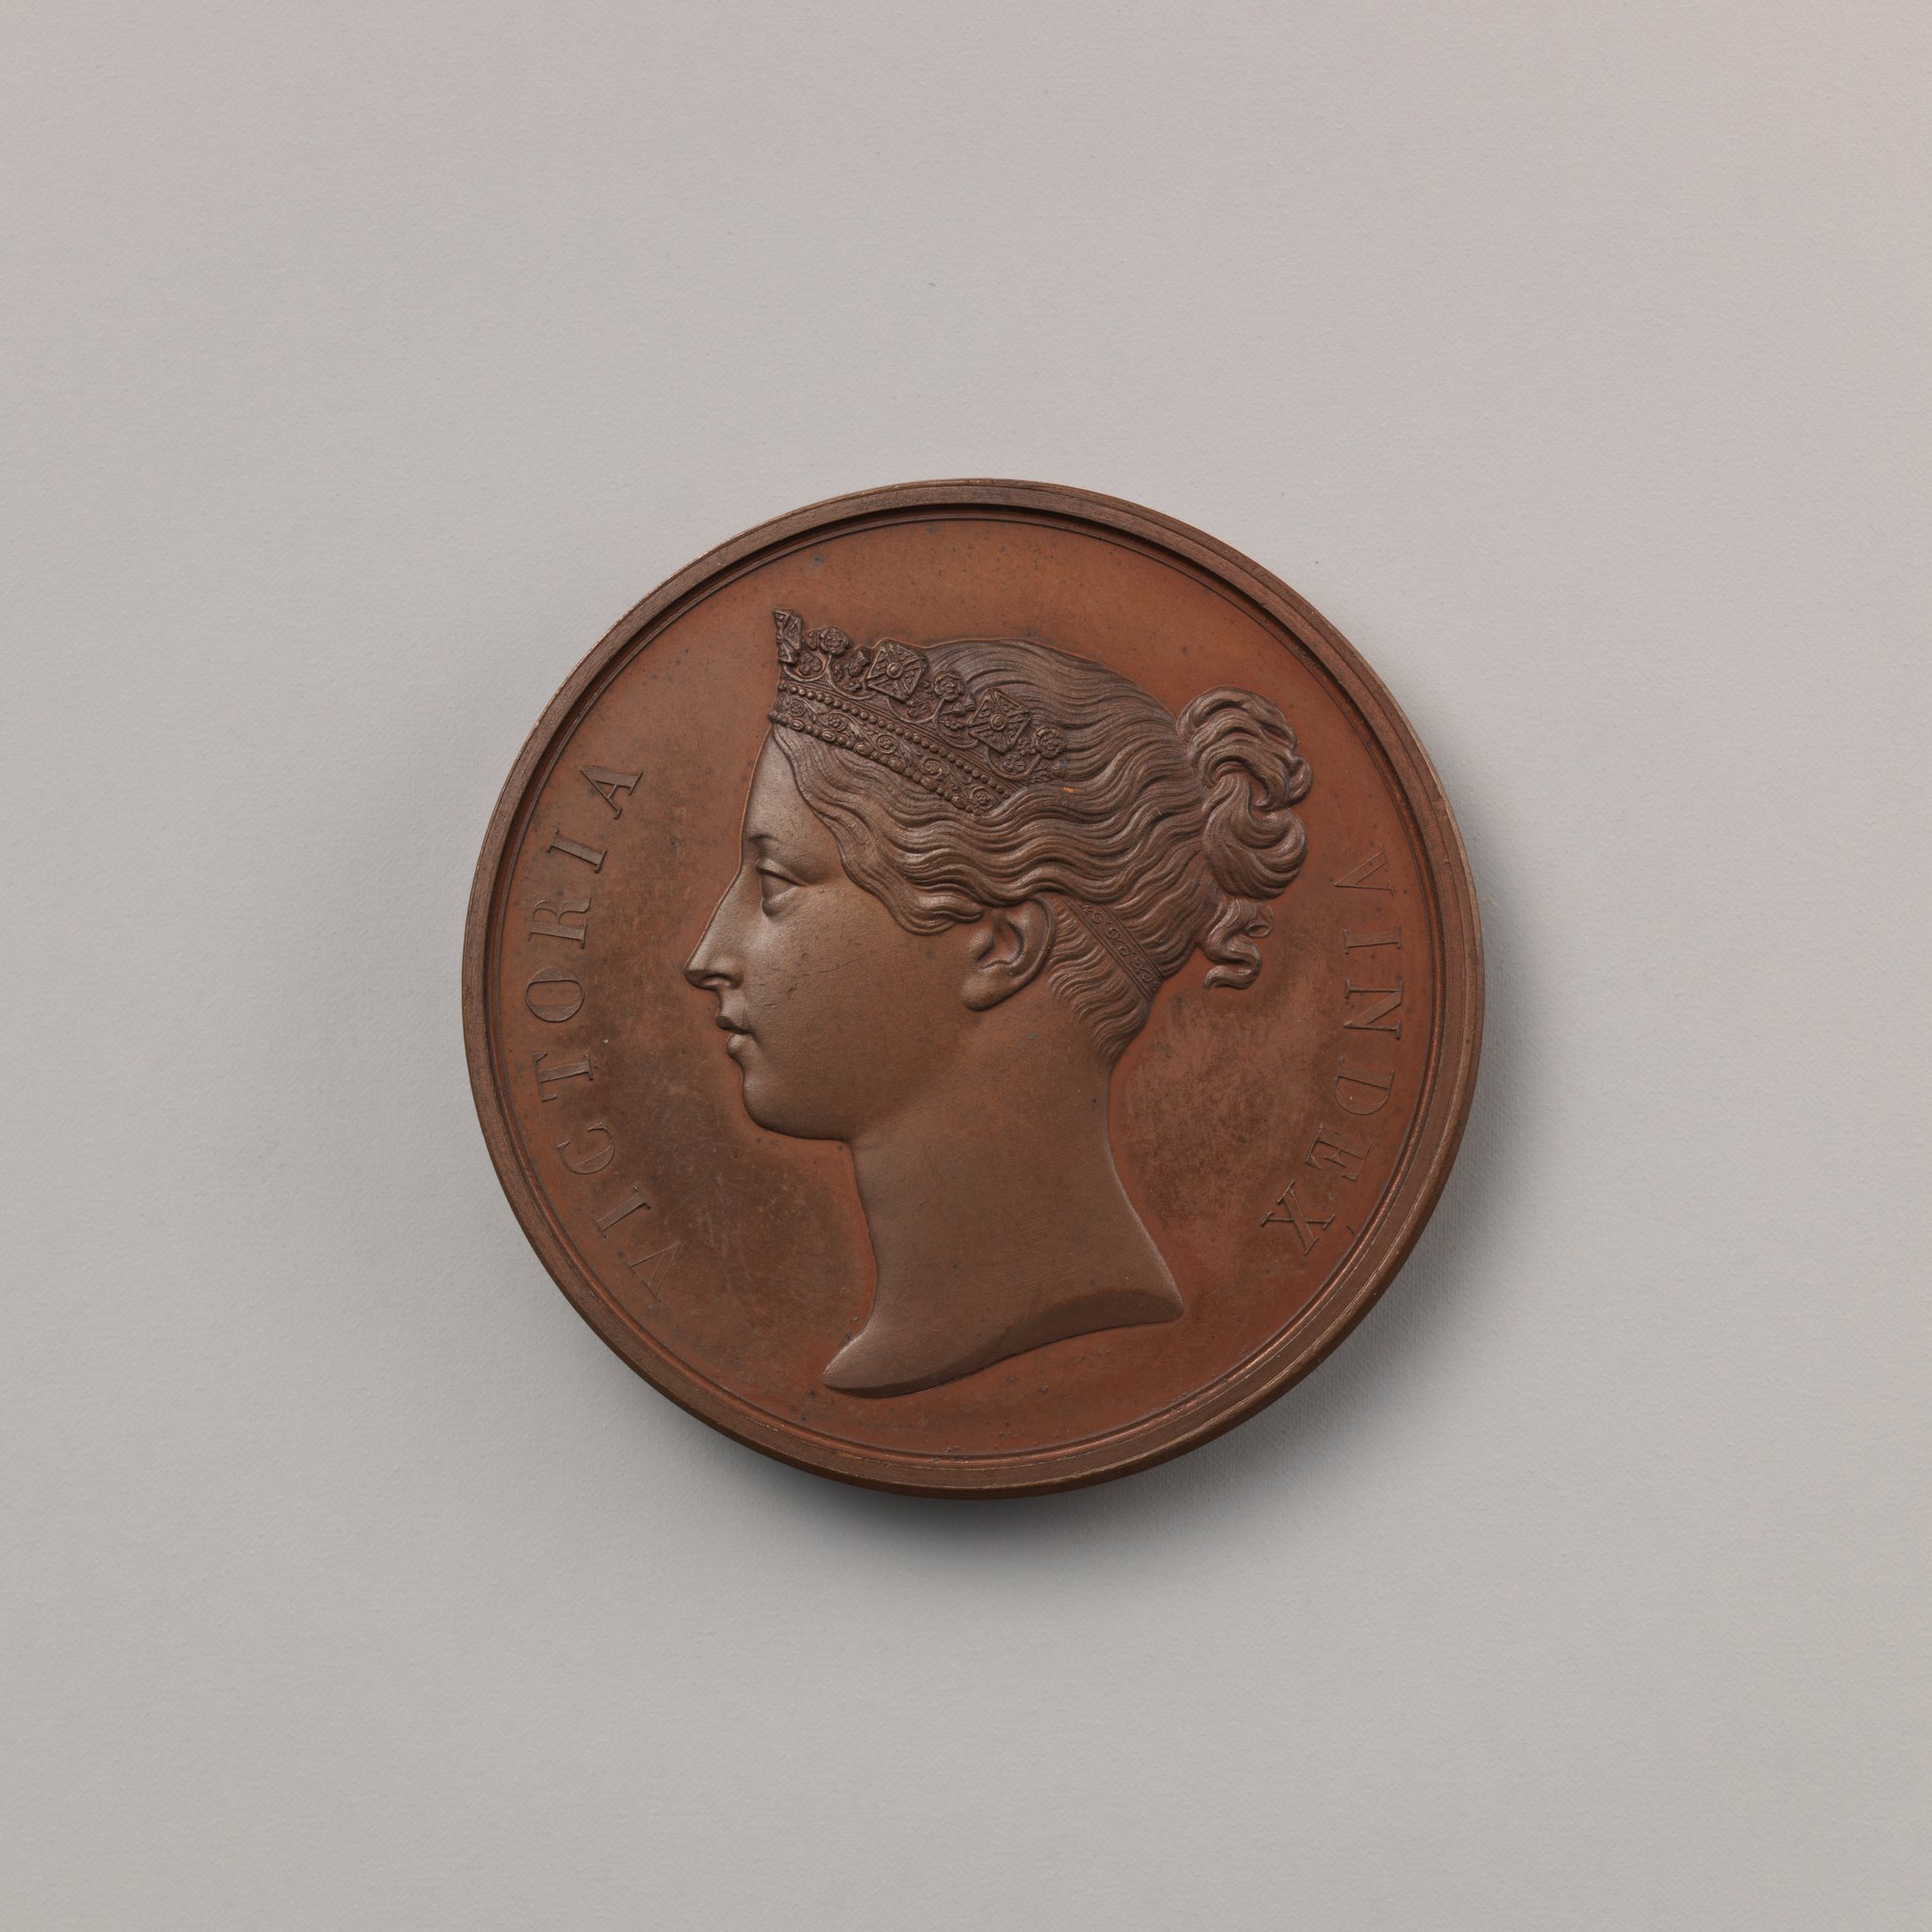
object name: medal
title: Second Form of the Afghanistan Medal, 1842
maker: william wyon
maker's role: artist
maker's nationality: british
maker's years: 1795-1851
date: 1842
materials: bronze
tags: profiles,women